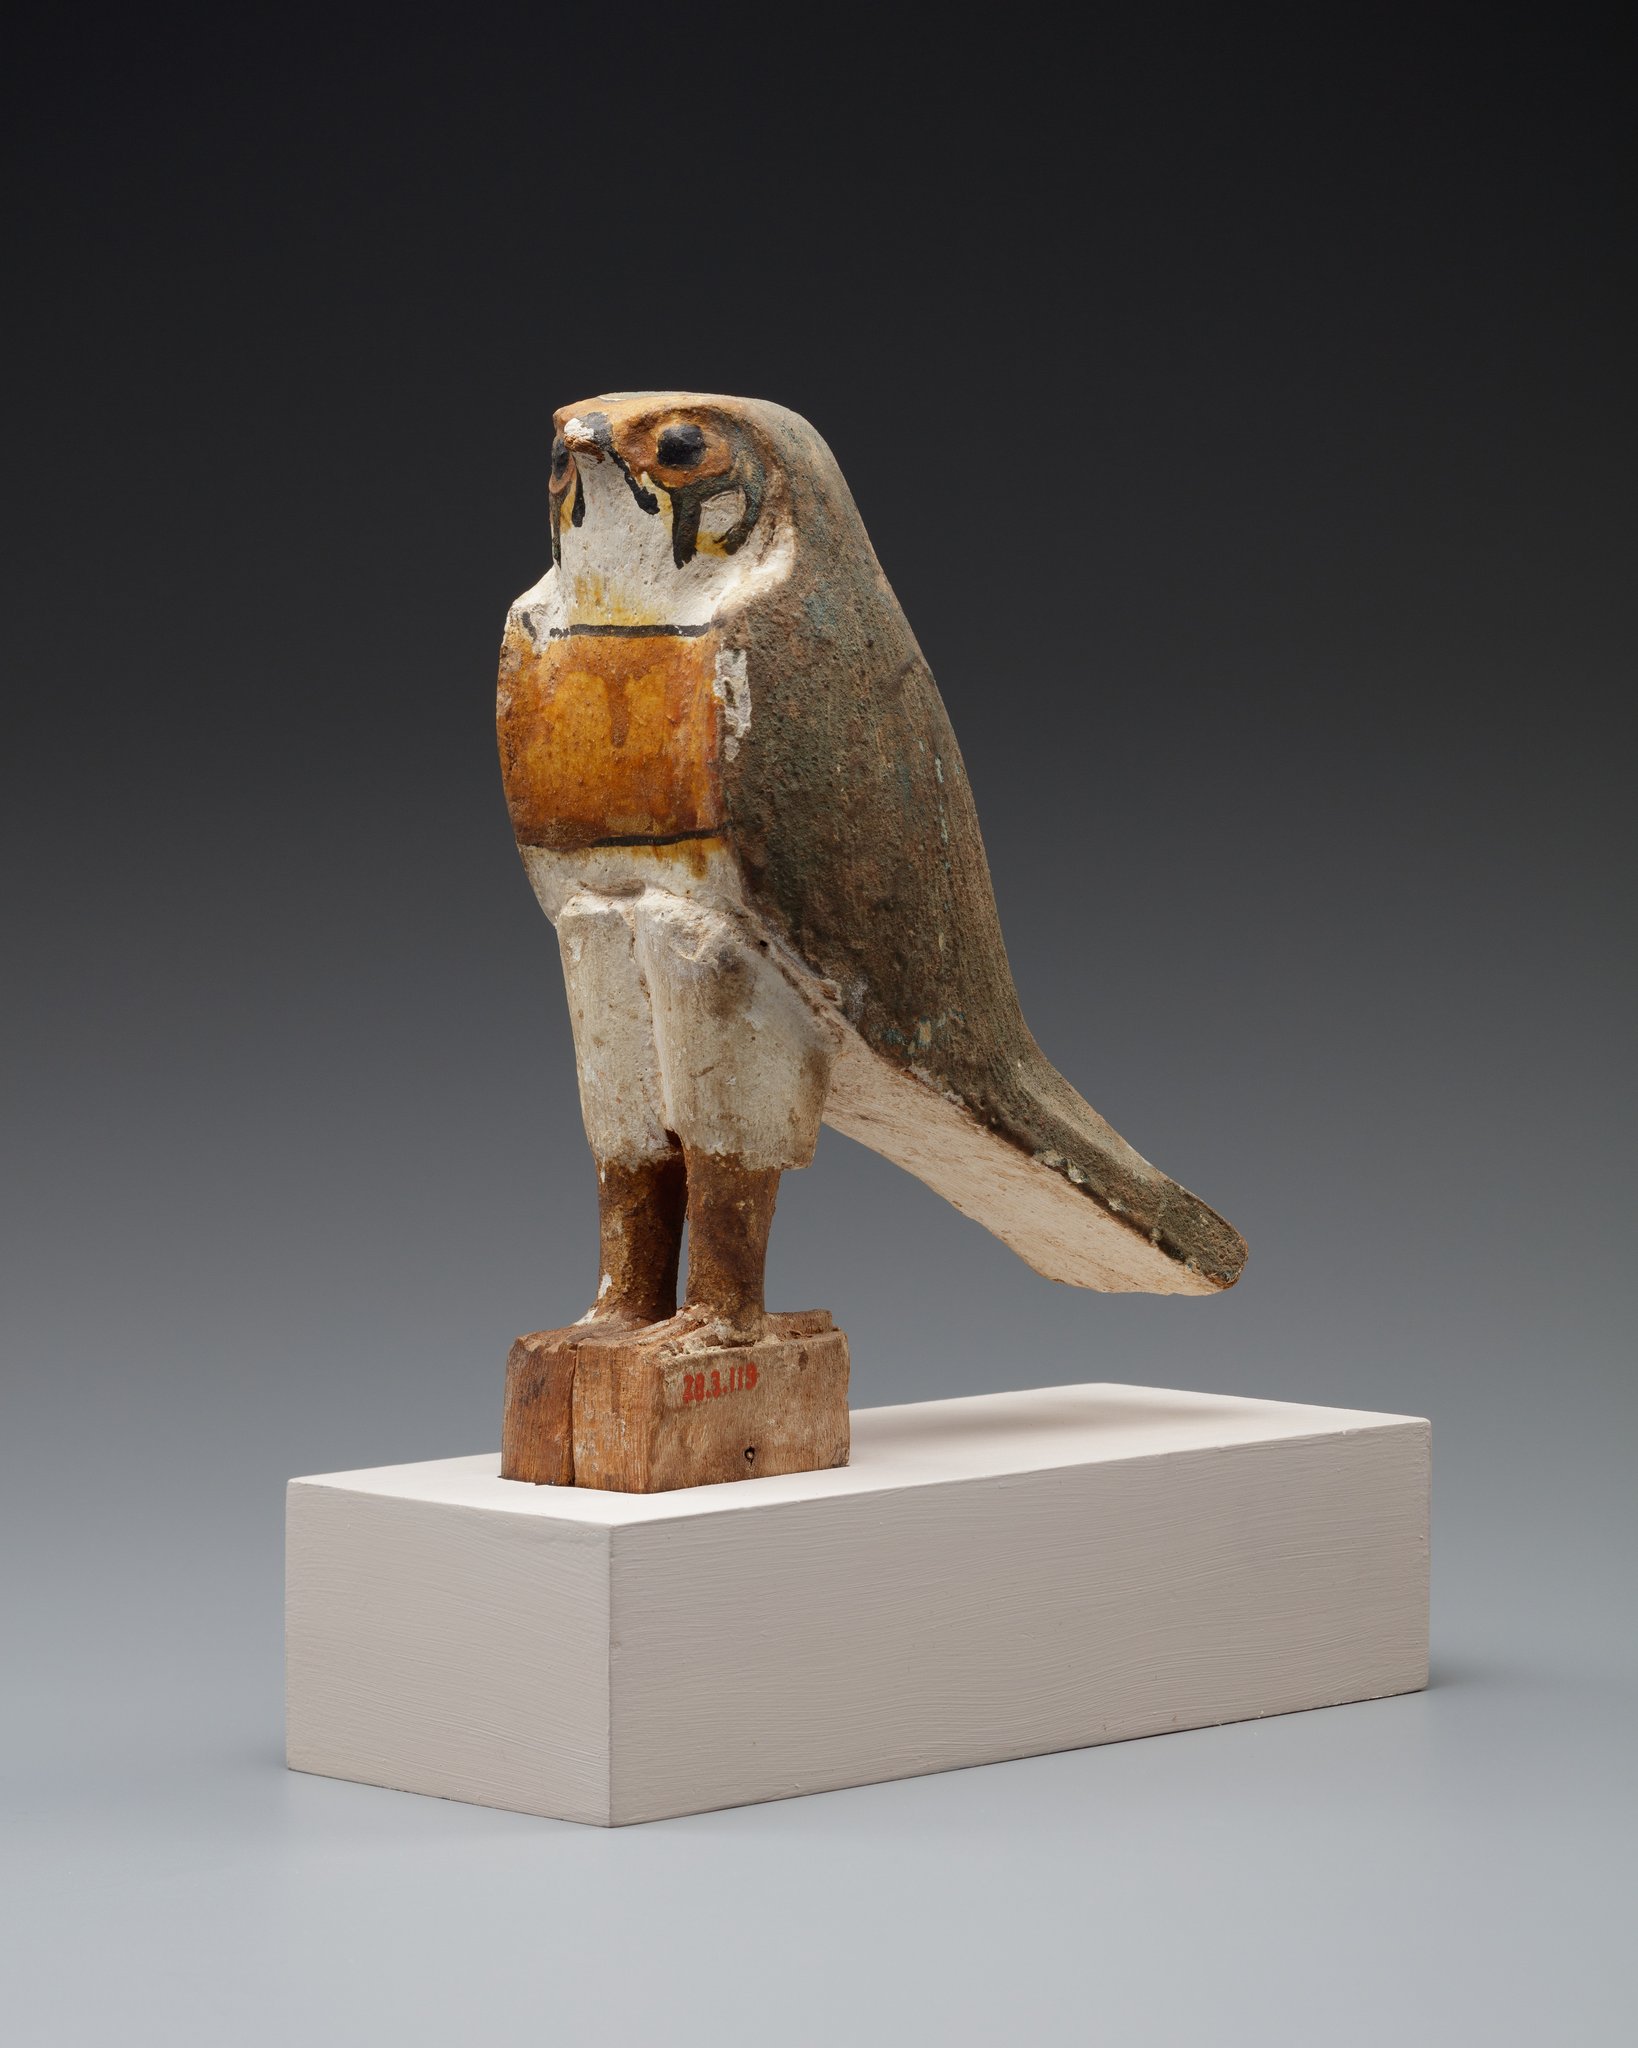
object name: figurine, falcon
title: Hawk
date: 664-525 BCE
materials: gesso, paint, wood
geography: egypt